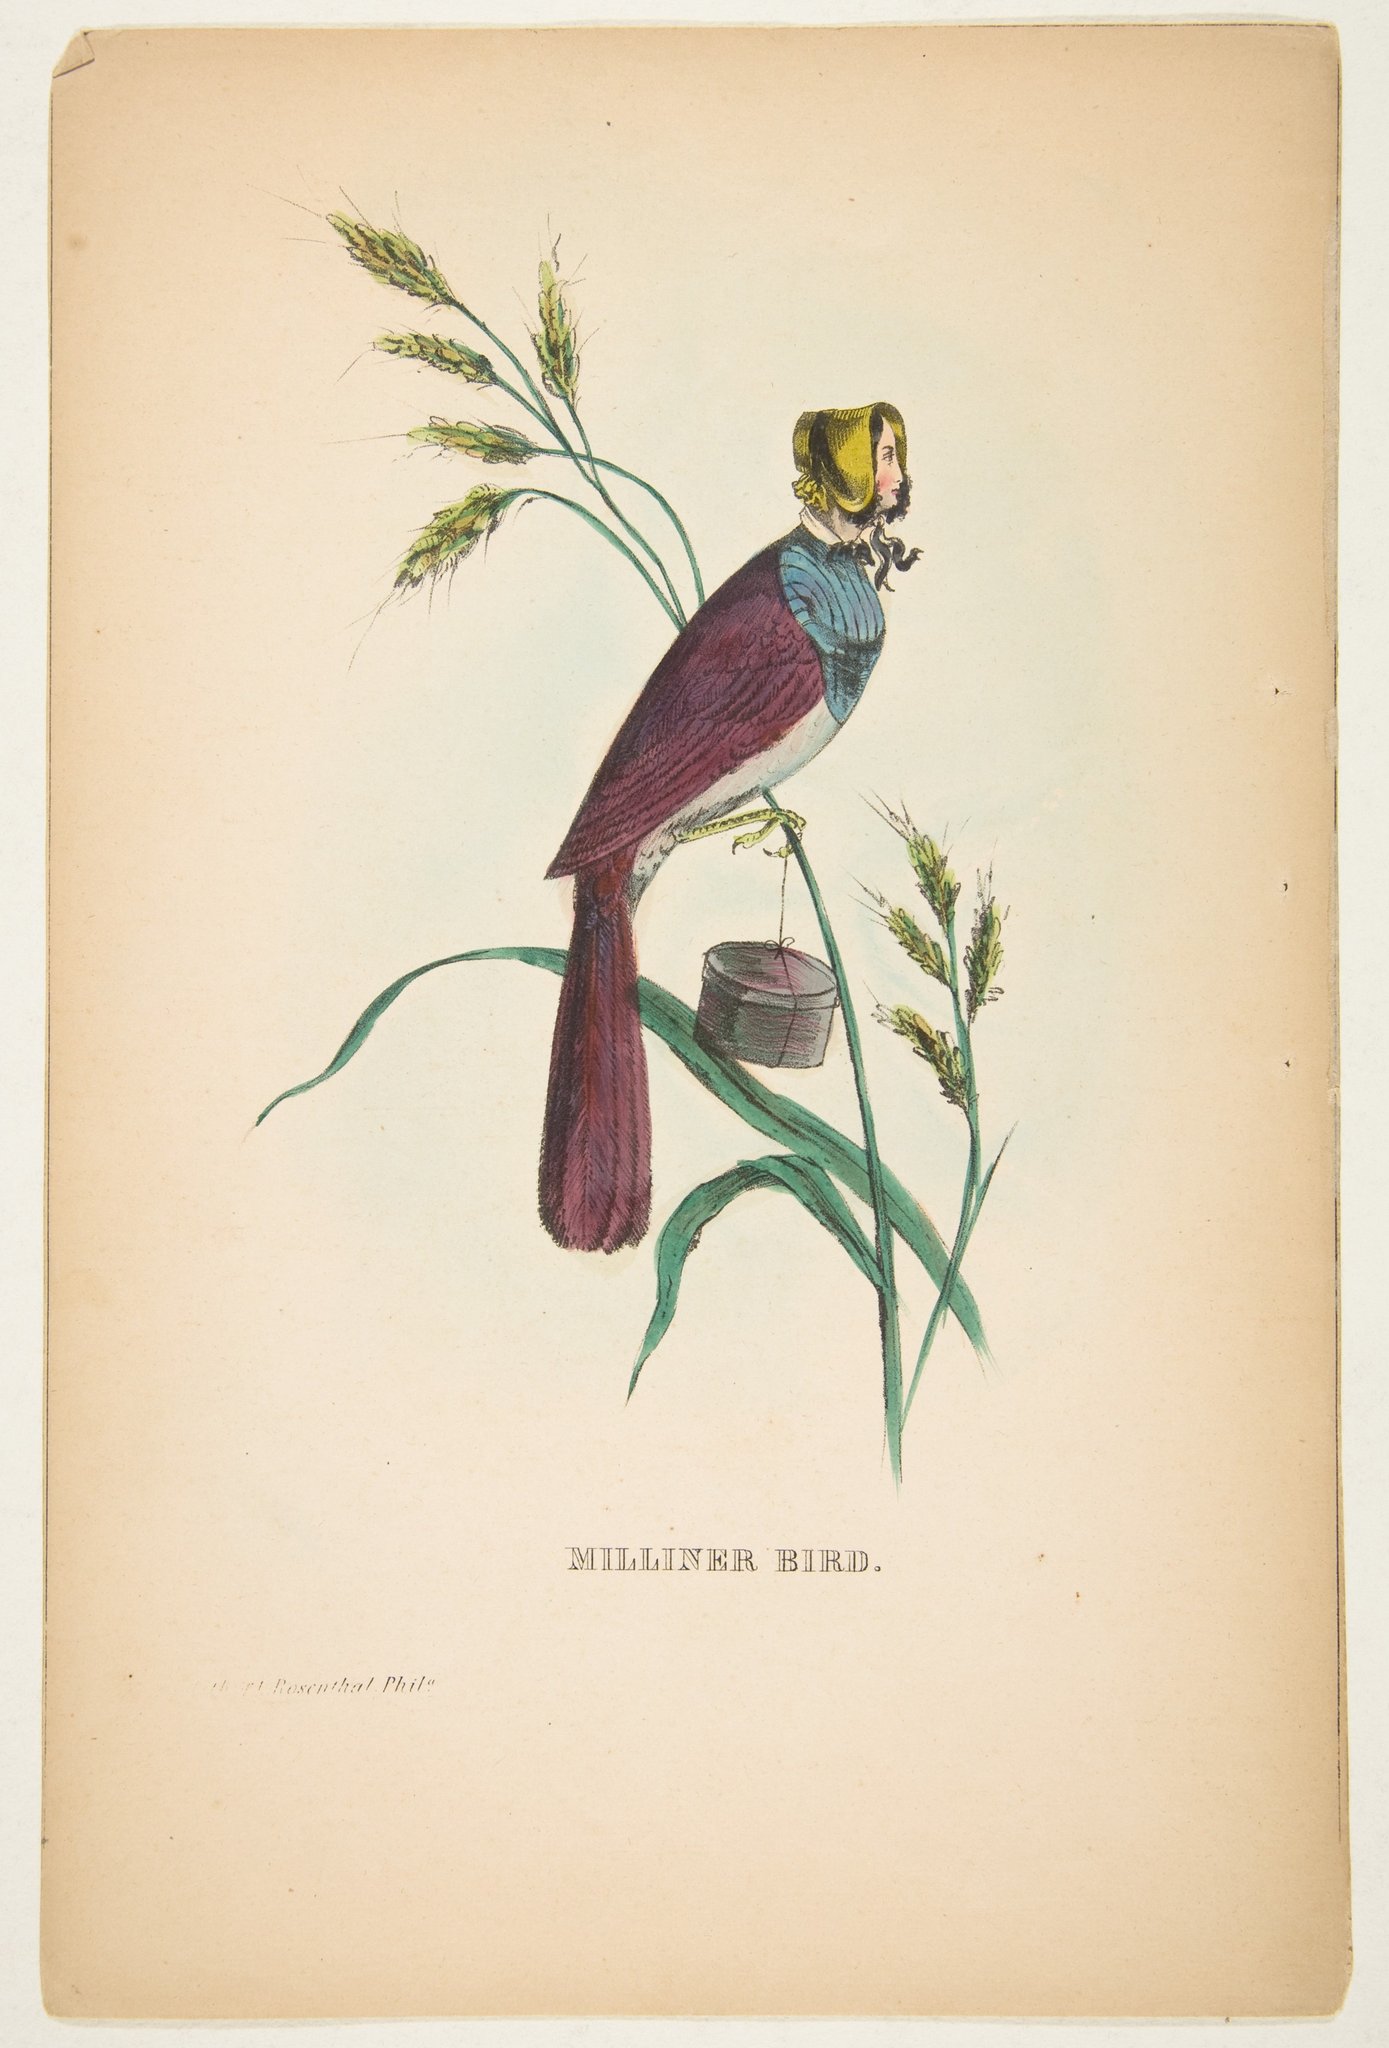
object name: print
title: Milliner Bird (Minnie Doyle), from "The Comic Natural History of the Human Race"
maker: henry louis stephens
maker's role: artist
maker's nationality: american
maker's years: 1824-1882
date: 1851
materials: watercolor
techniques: lithograph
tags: birds,satire